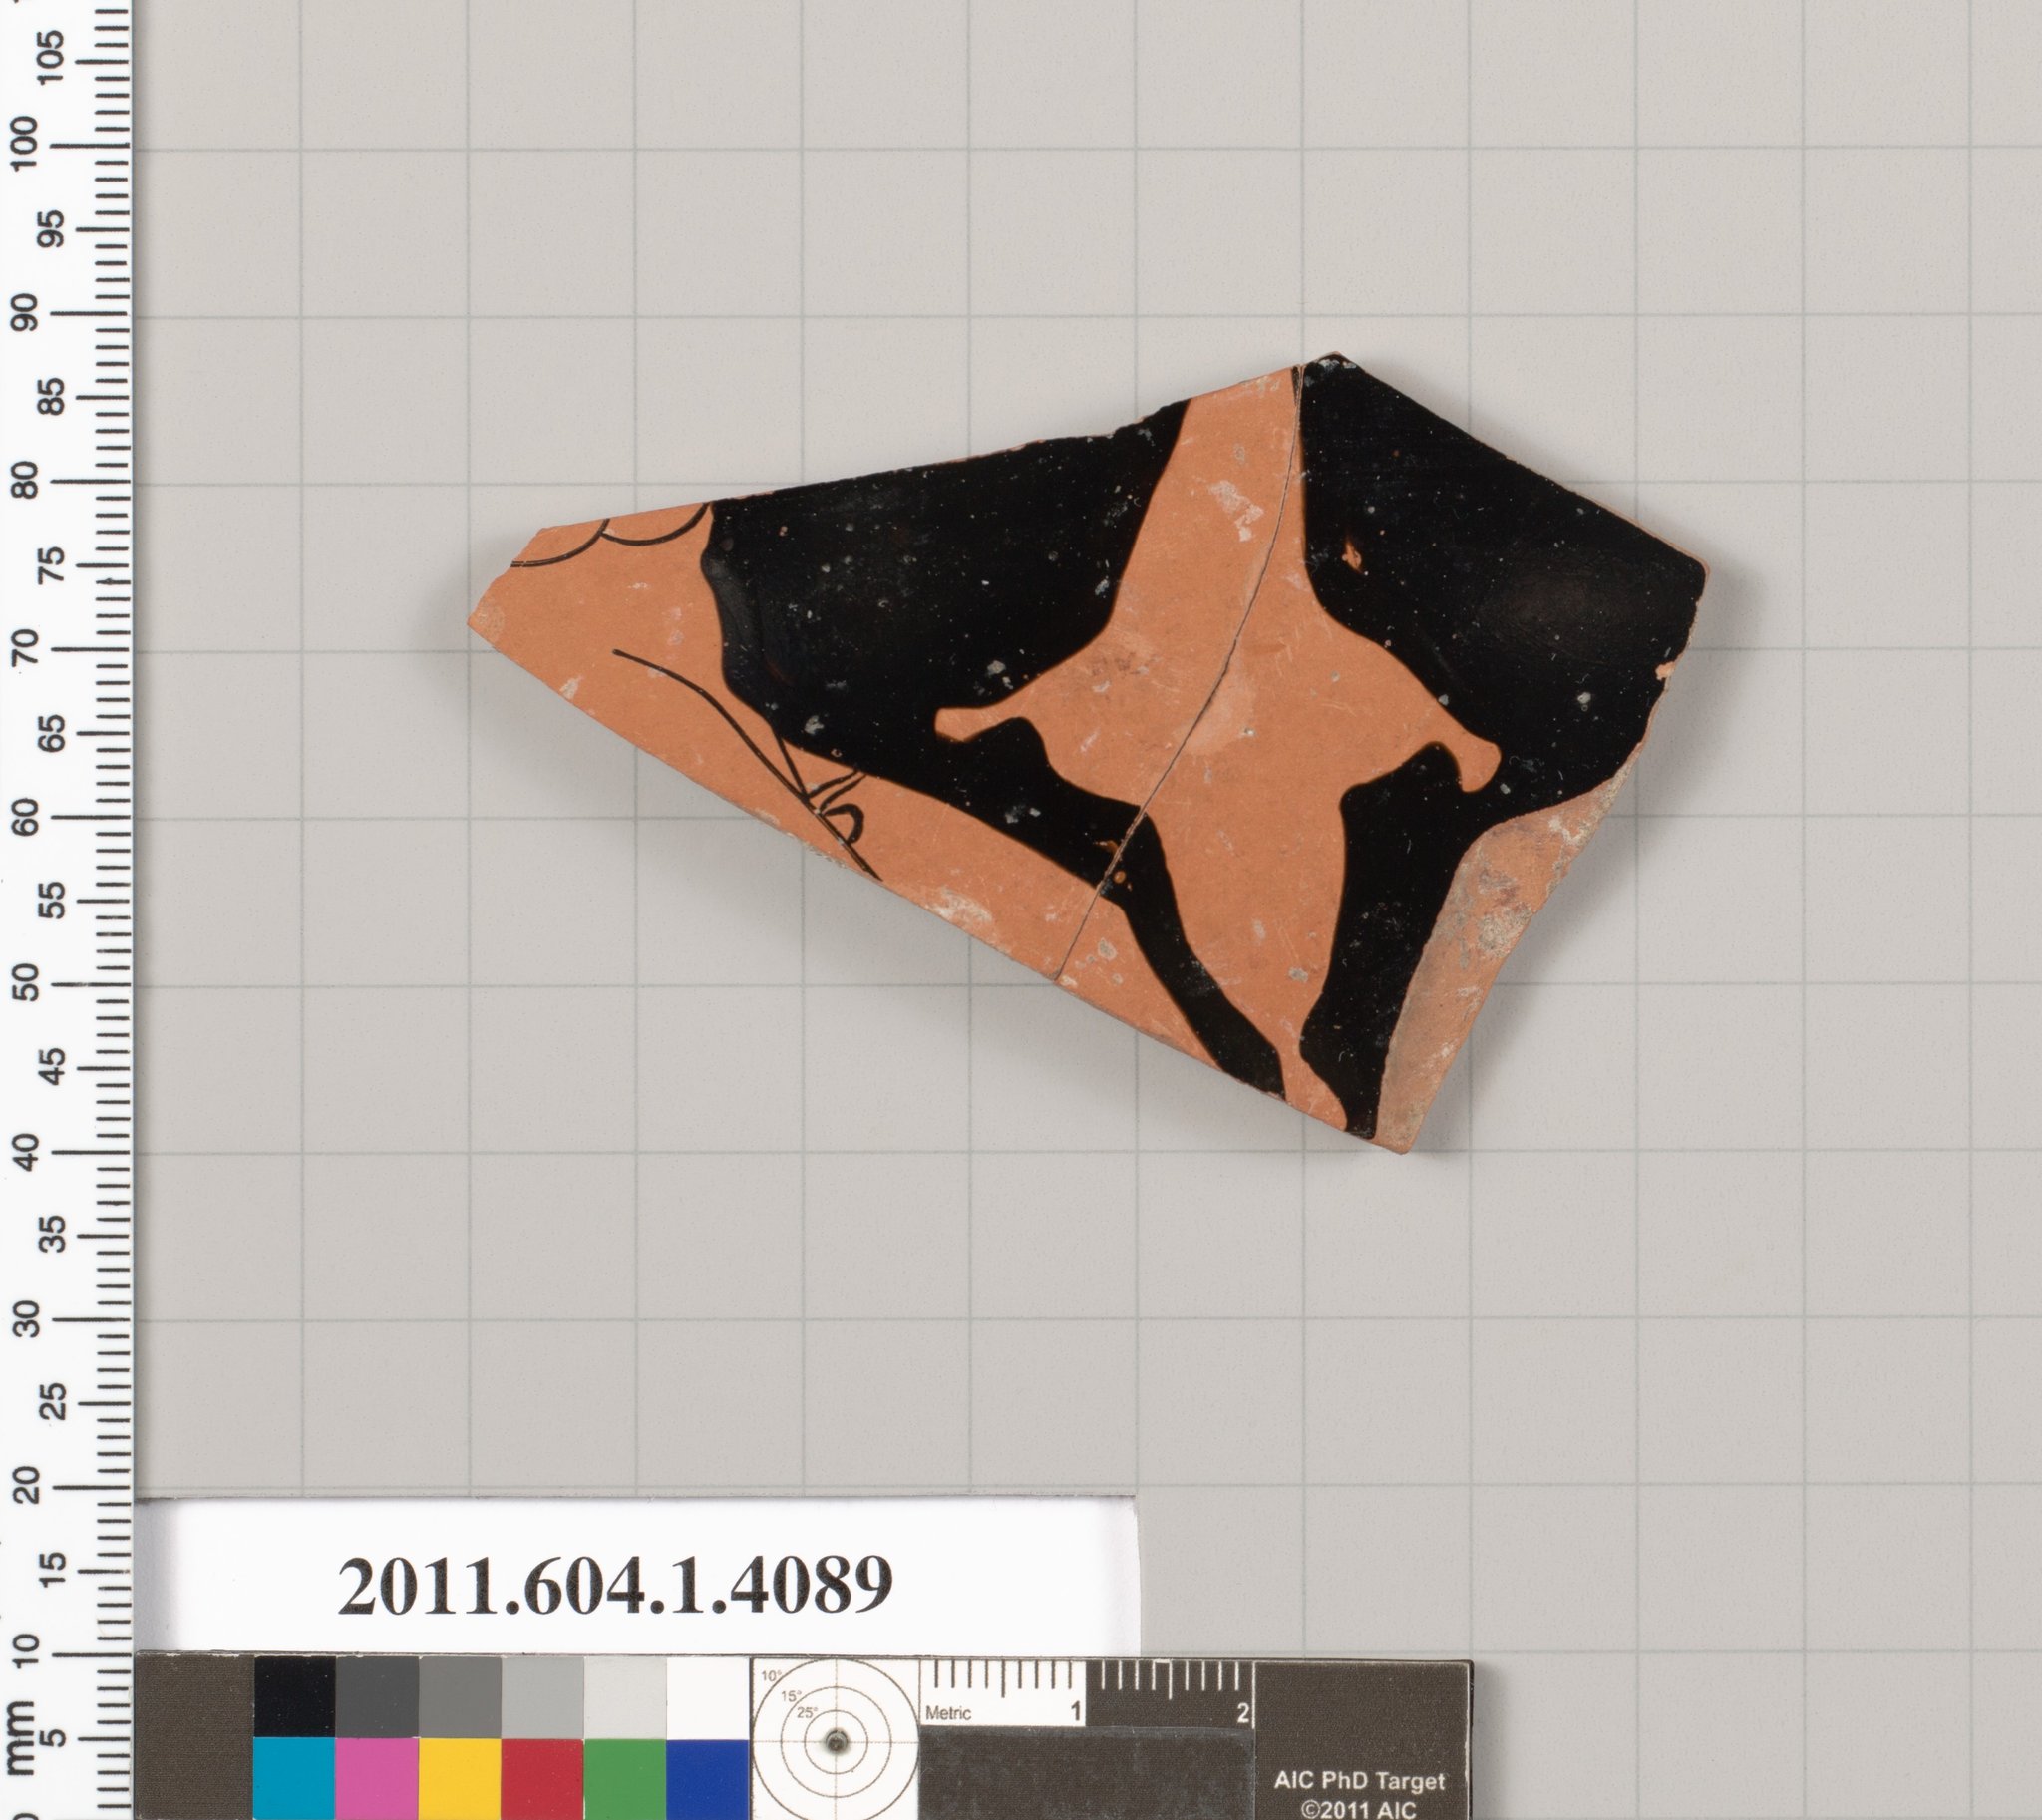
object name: kylix fragment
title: Terracotta fragment of a kylix (drinking cup)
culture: greek, attic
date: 510-480 BCE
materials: terracotta